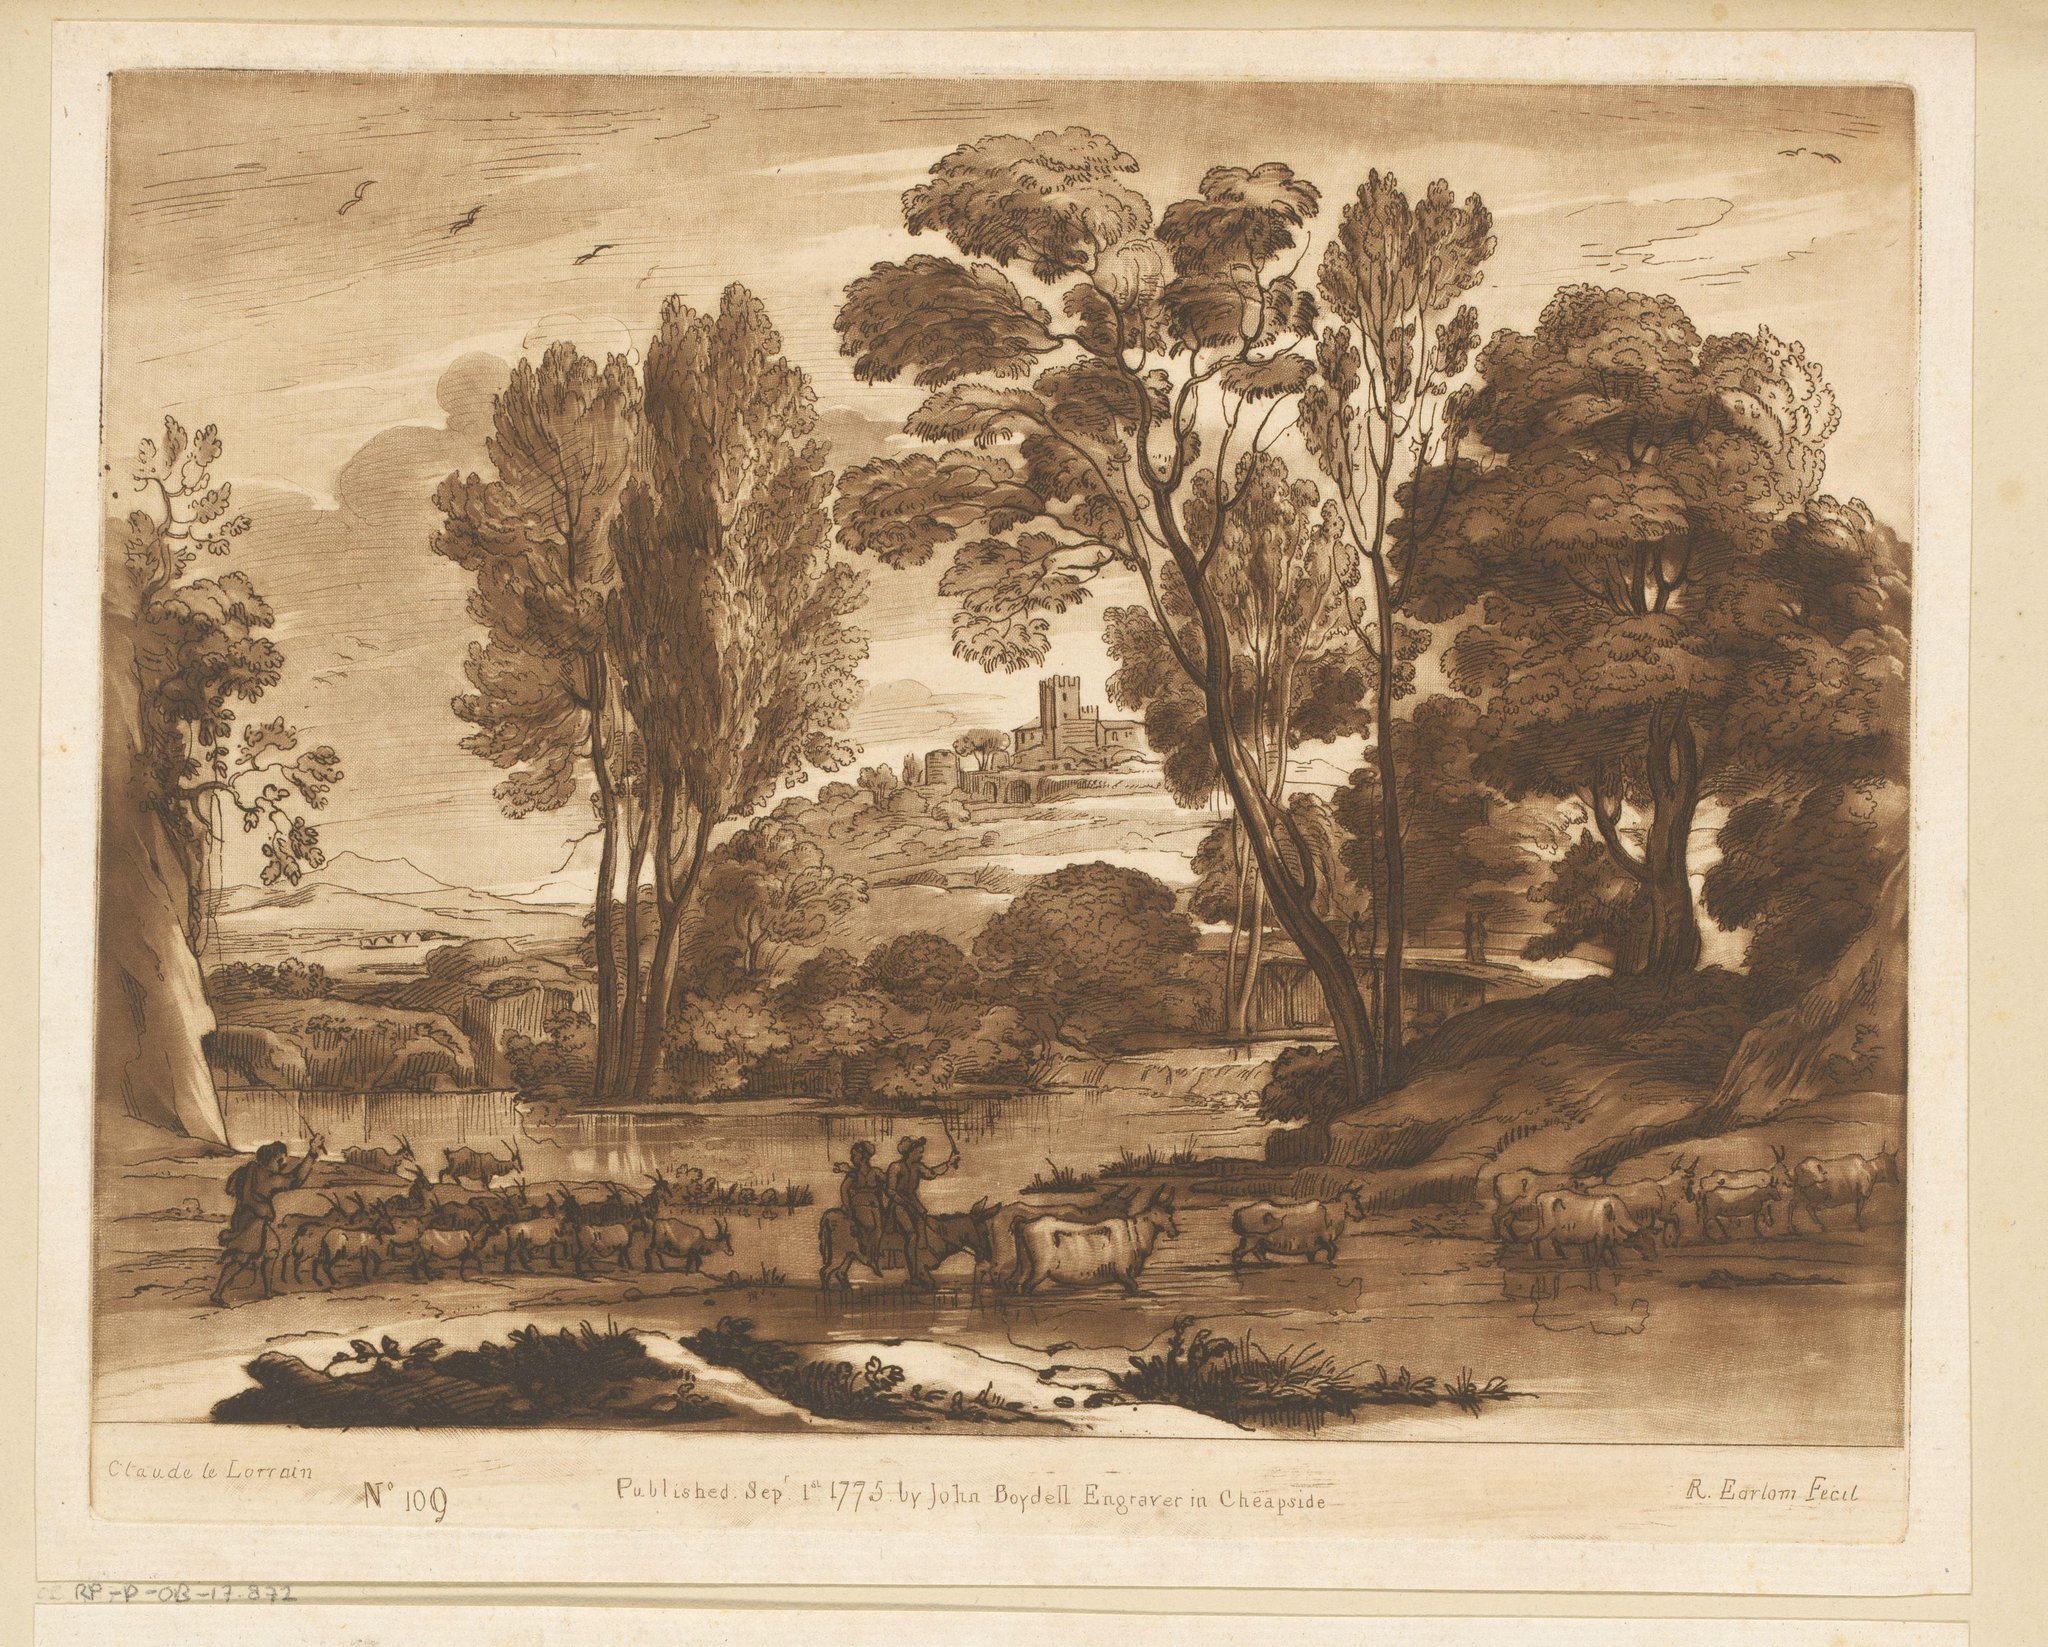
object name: print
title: Prenten naar tekeningen van Claude Lorrain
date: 1775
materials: paper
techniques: etching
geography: london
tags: crossing a river, city-view, and landscape with man-made constructions - ii - ideal landscapes, cattle driving, cattle driver, pastorals, arcadian scenes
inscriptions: date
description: Vanaf 1774 publiceerde John Boydell tweehonderd prenten naar het tekeningenboek Liber Veritatis van Claude Lorrain, in het bezit van de hertogen van Cavendish. Deze prenten werden vanaf 1777 in twee volumes gebundeld uitgegeven.